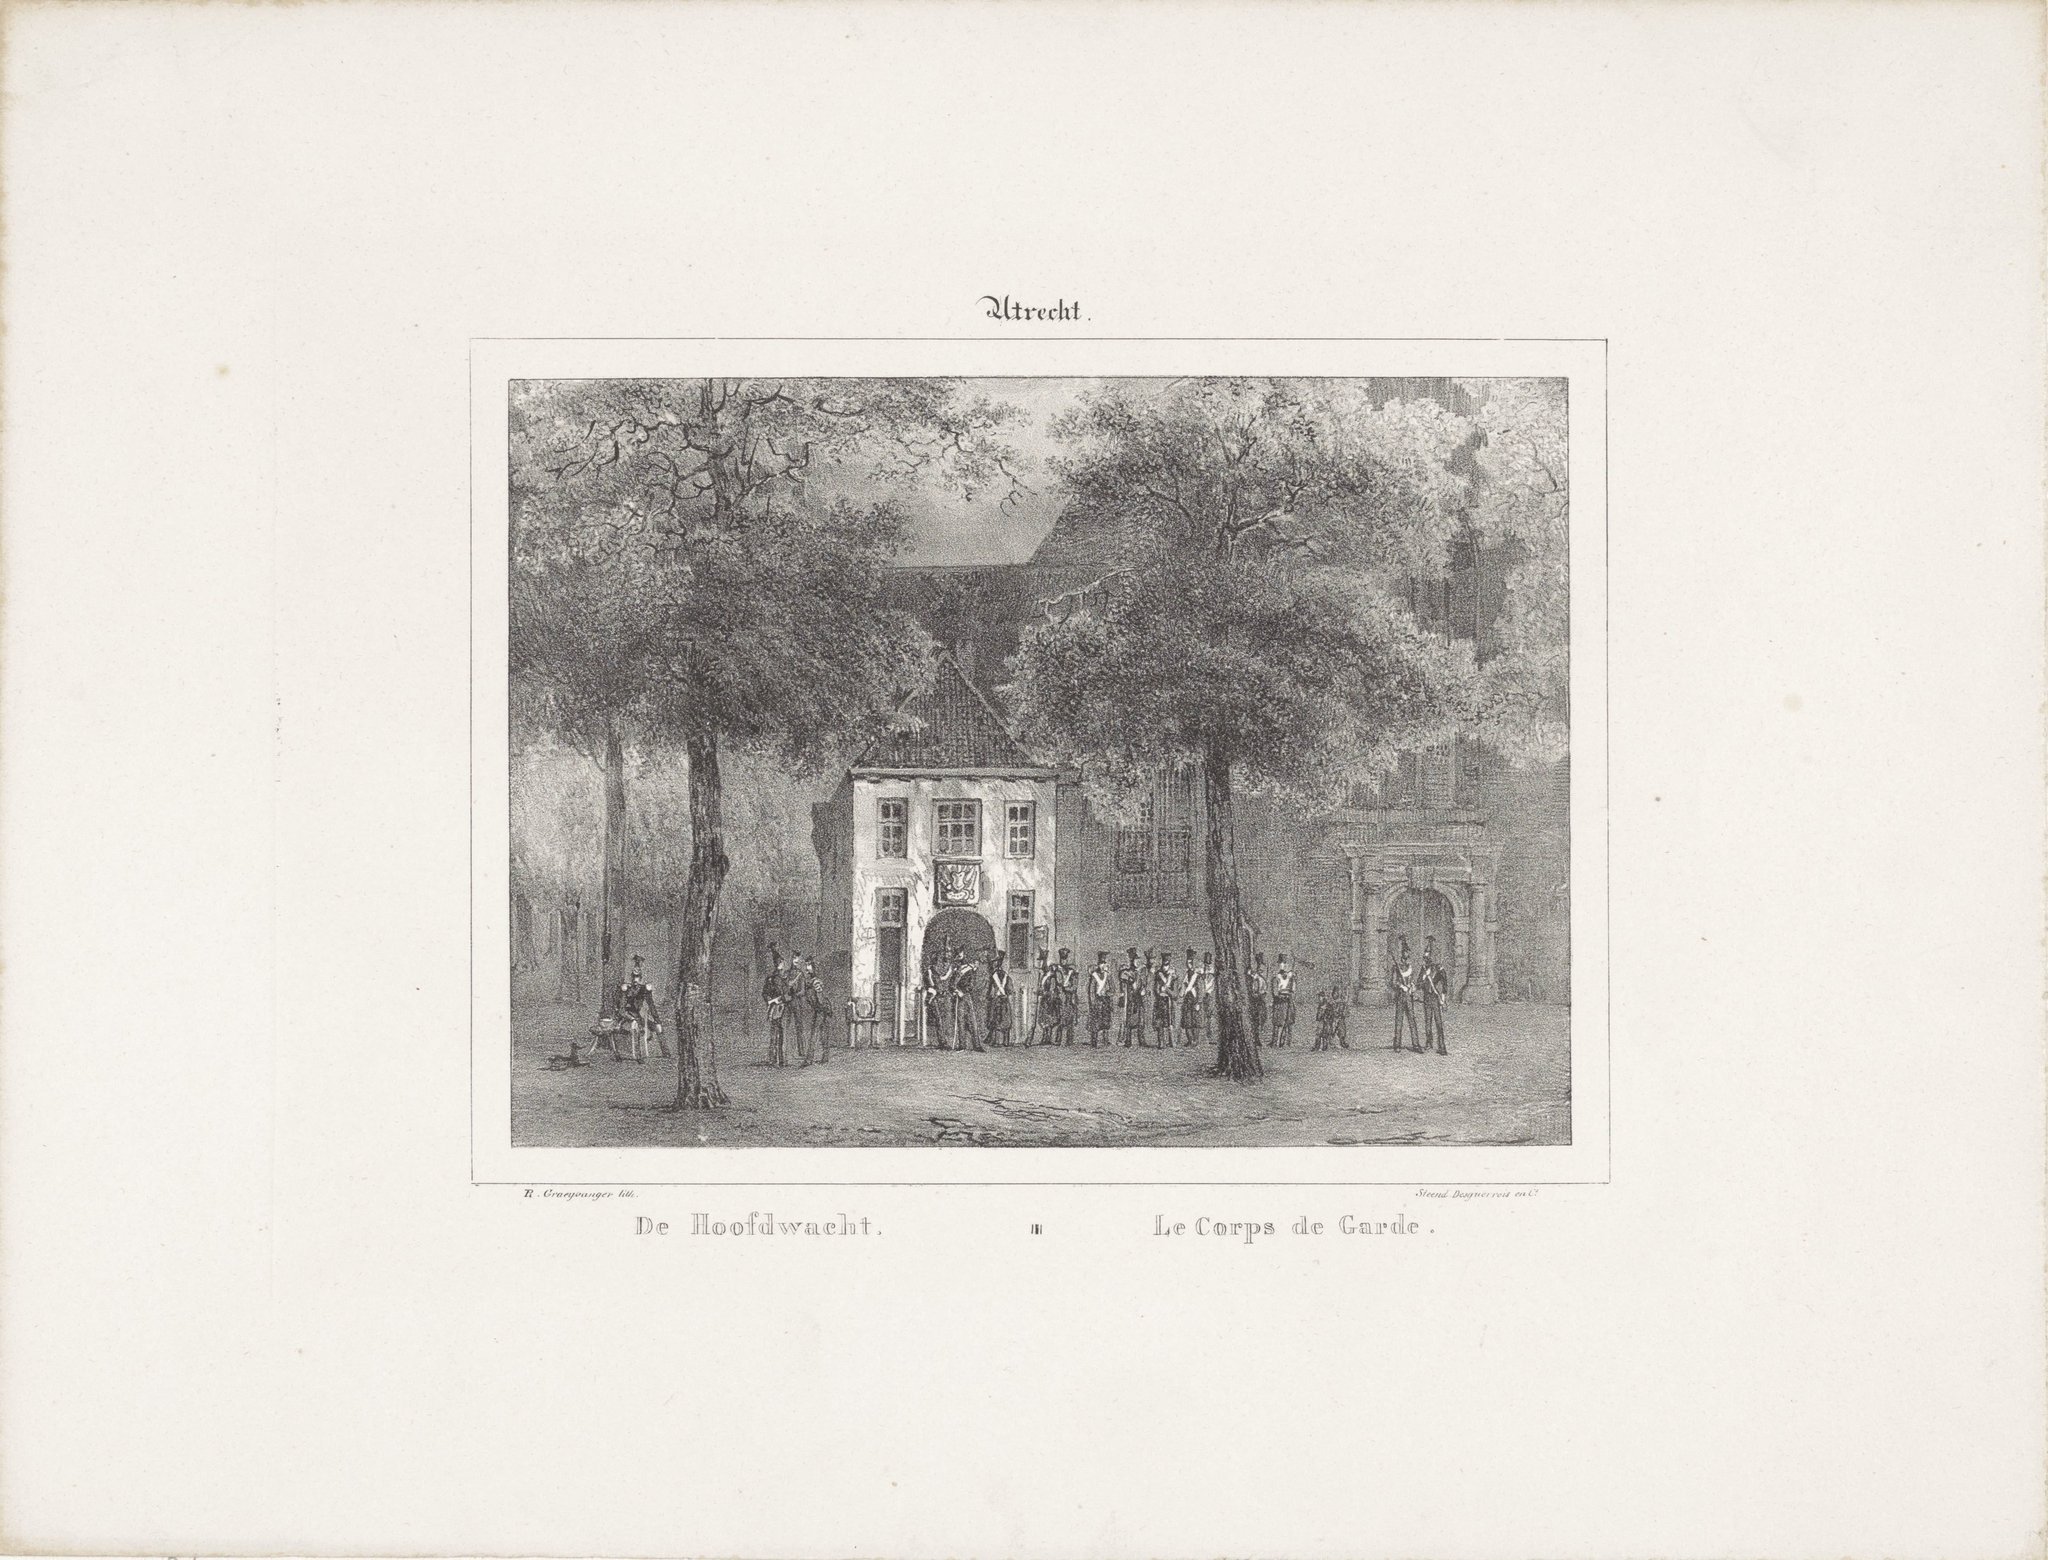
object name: print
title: Hoofdwacht in Utrecht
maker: reinier craeyvanger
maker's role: draughtsman, print maker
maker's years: 1812-1880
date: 1830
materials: paper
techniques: lithograph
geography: amsterdam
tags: in the guard-room, 'kortegaard', utrecht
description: Het gebouw staat tegen de Janskerk aan op het Janskerkhof. Ervoor staat een groep schutters in de rij.